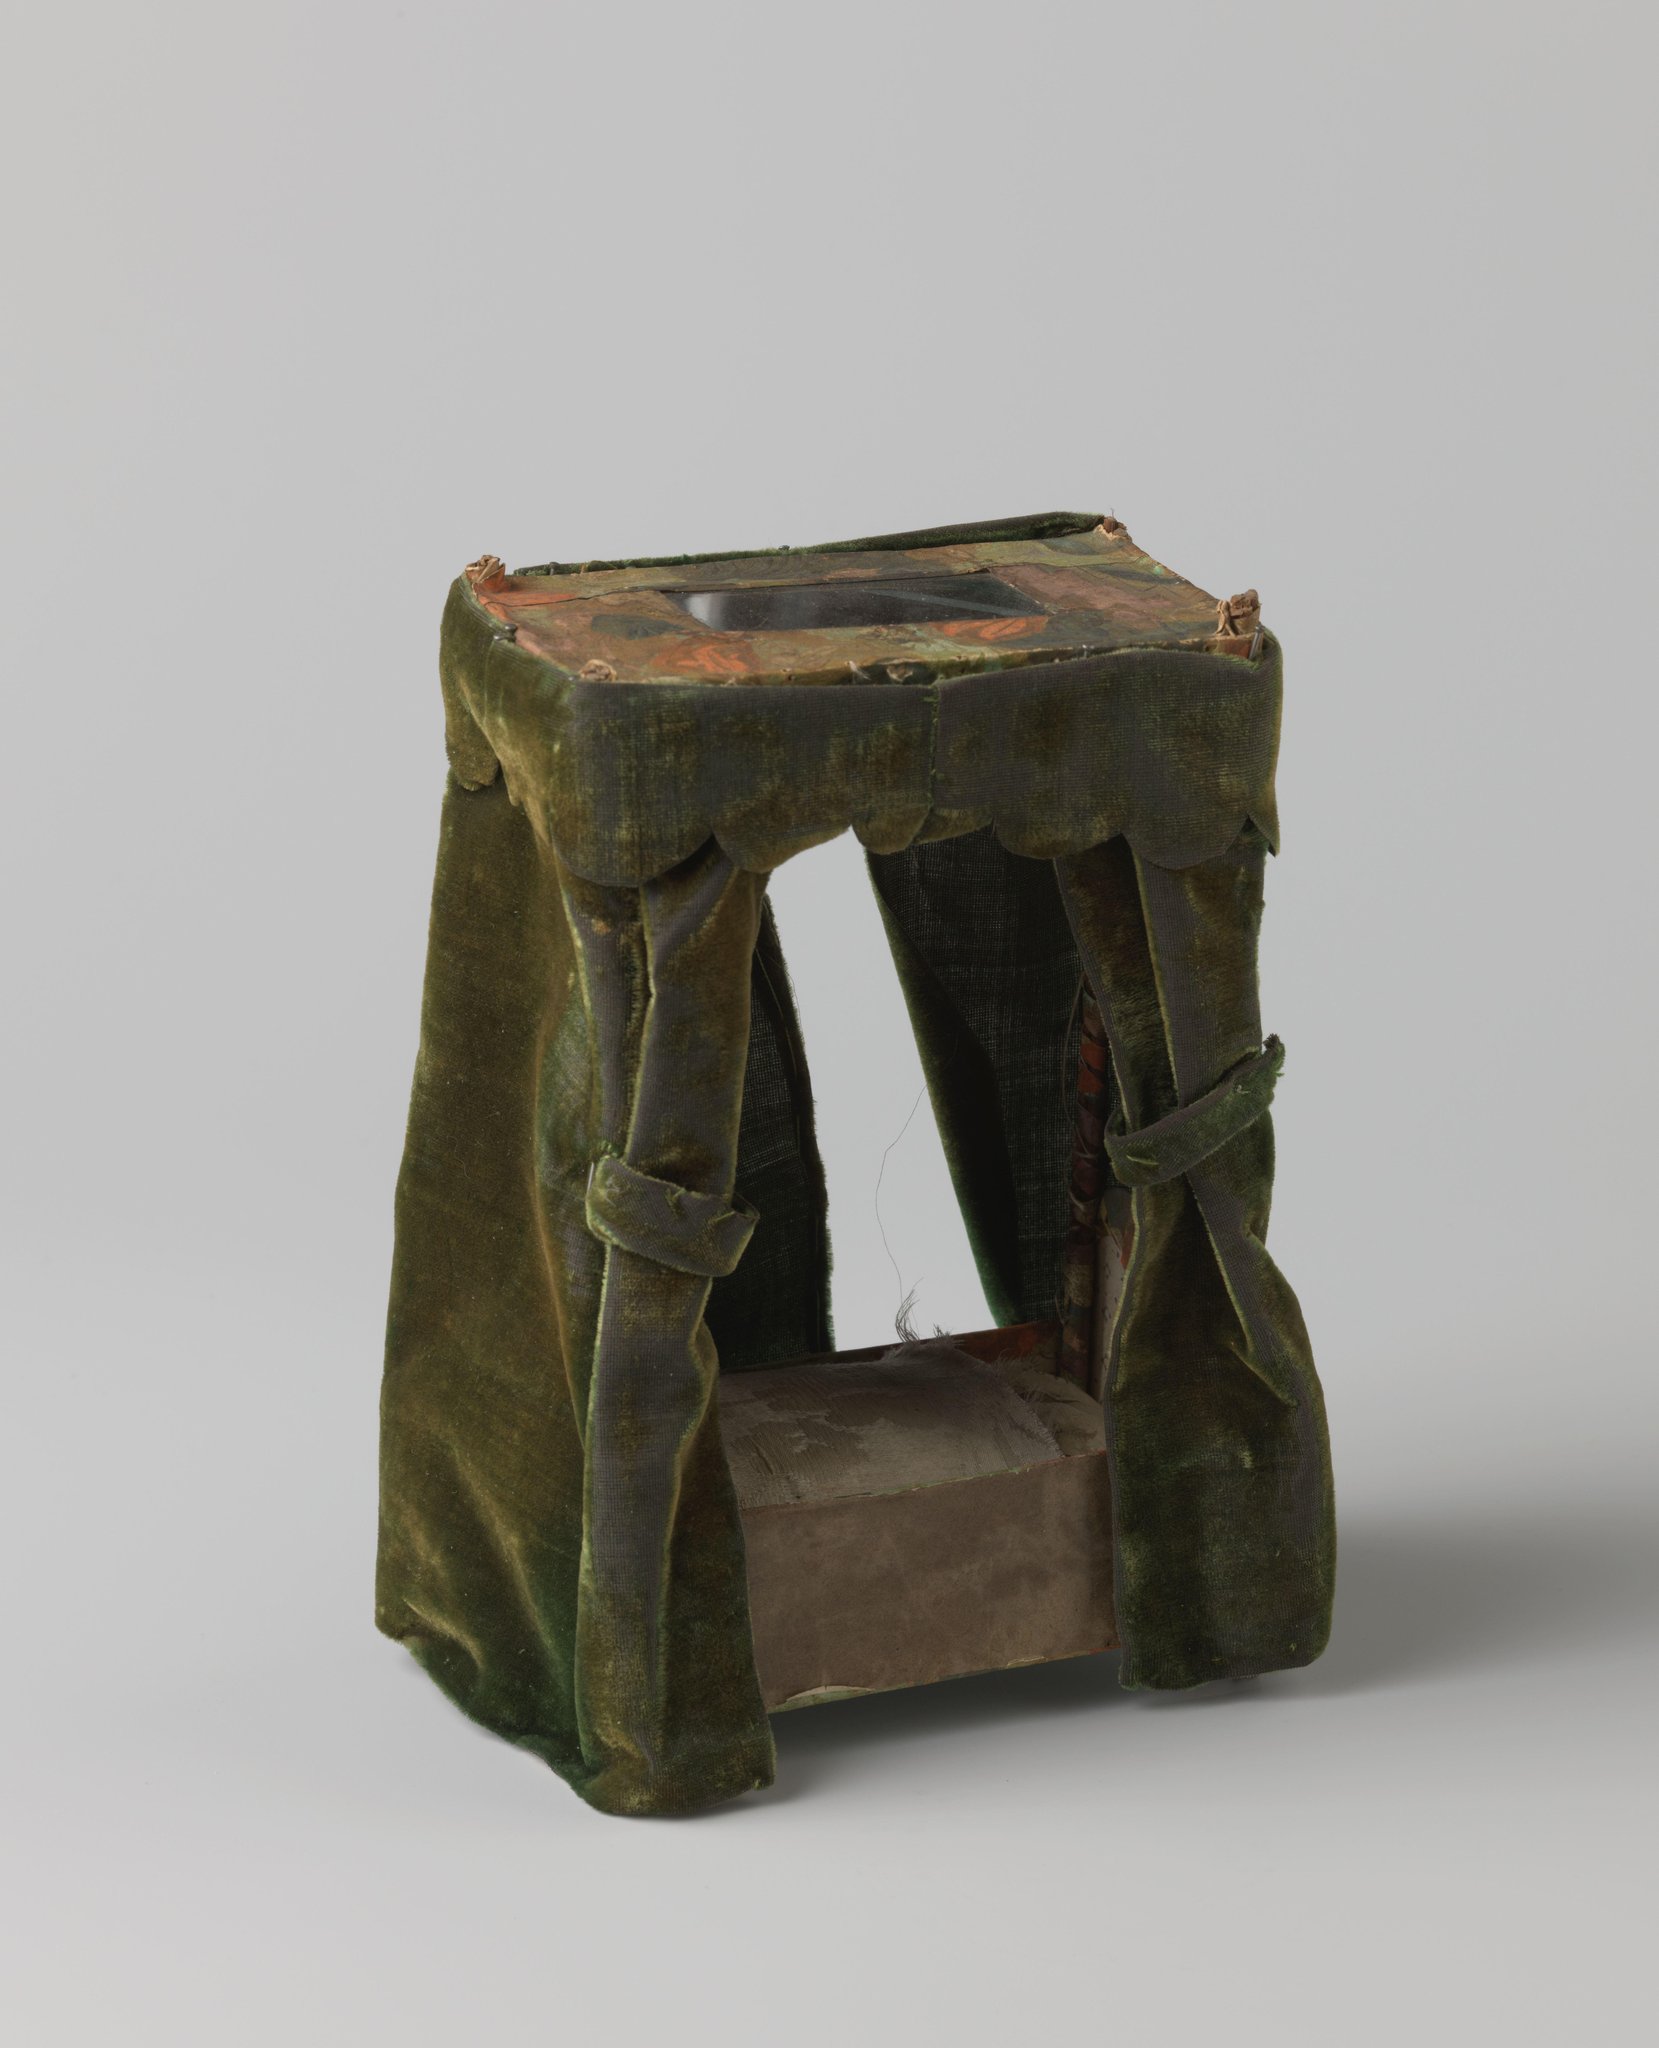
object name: canopy bed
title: Hemelbed, met hemel en val van groen fluweel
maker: Anonymous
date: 1750-1800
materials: glass, paper, board, silk, velvet, wood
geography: amsterdam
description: Hemelbed met vier stijlen, vervaardigd van takjes en karton, omwonden en beplakt met veelkleurig bedrukt papier. In de hemel zit een glazen ruitje, om de hemel een gordijn en een val van groen fluweel, grof afgewerkt.